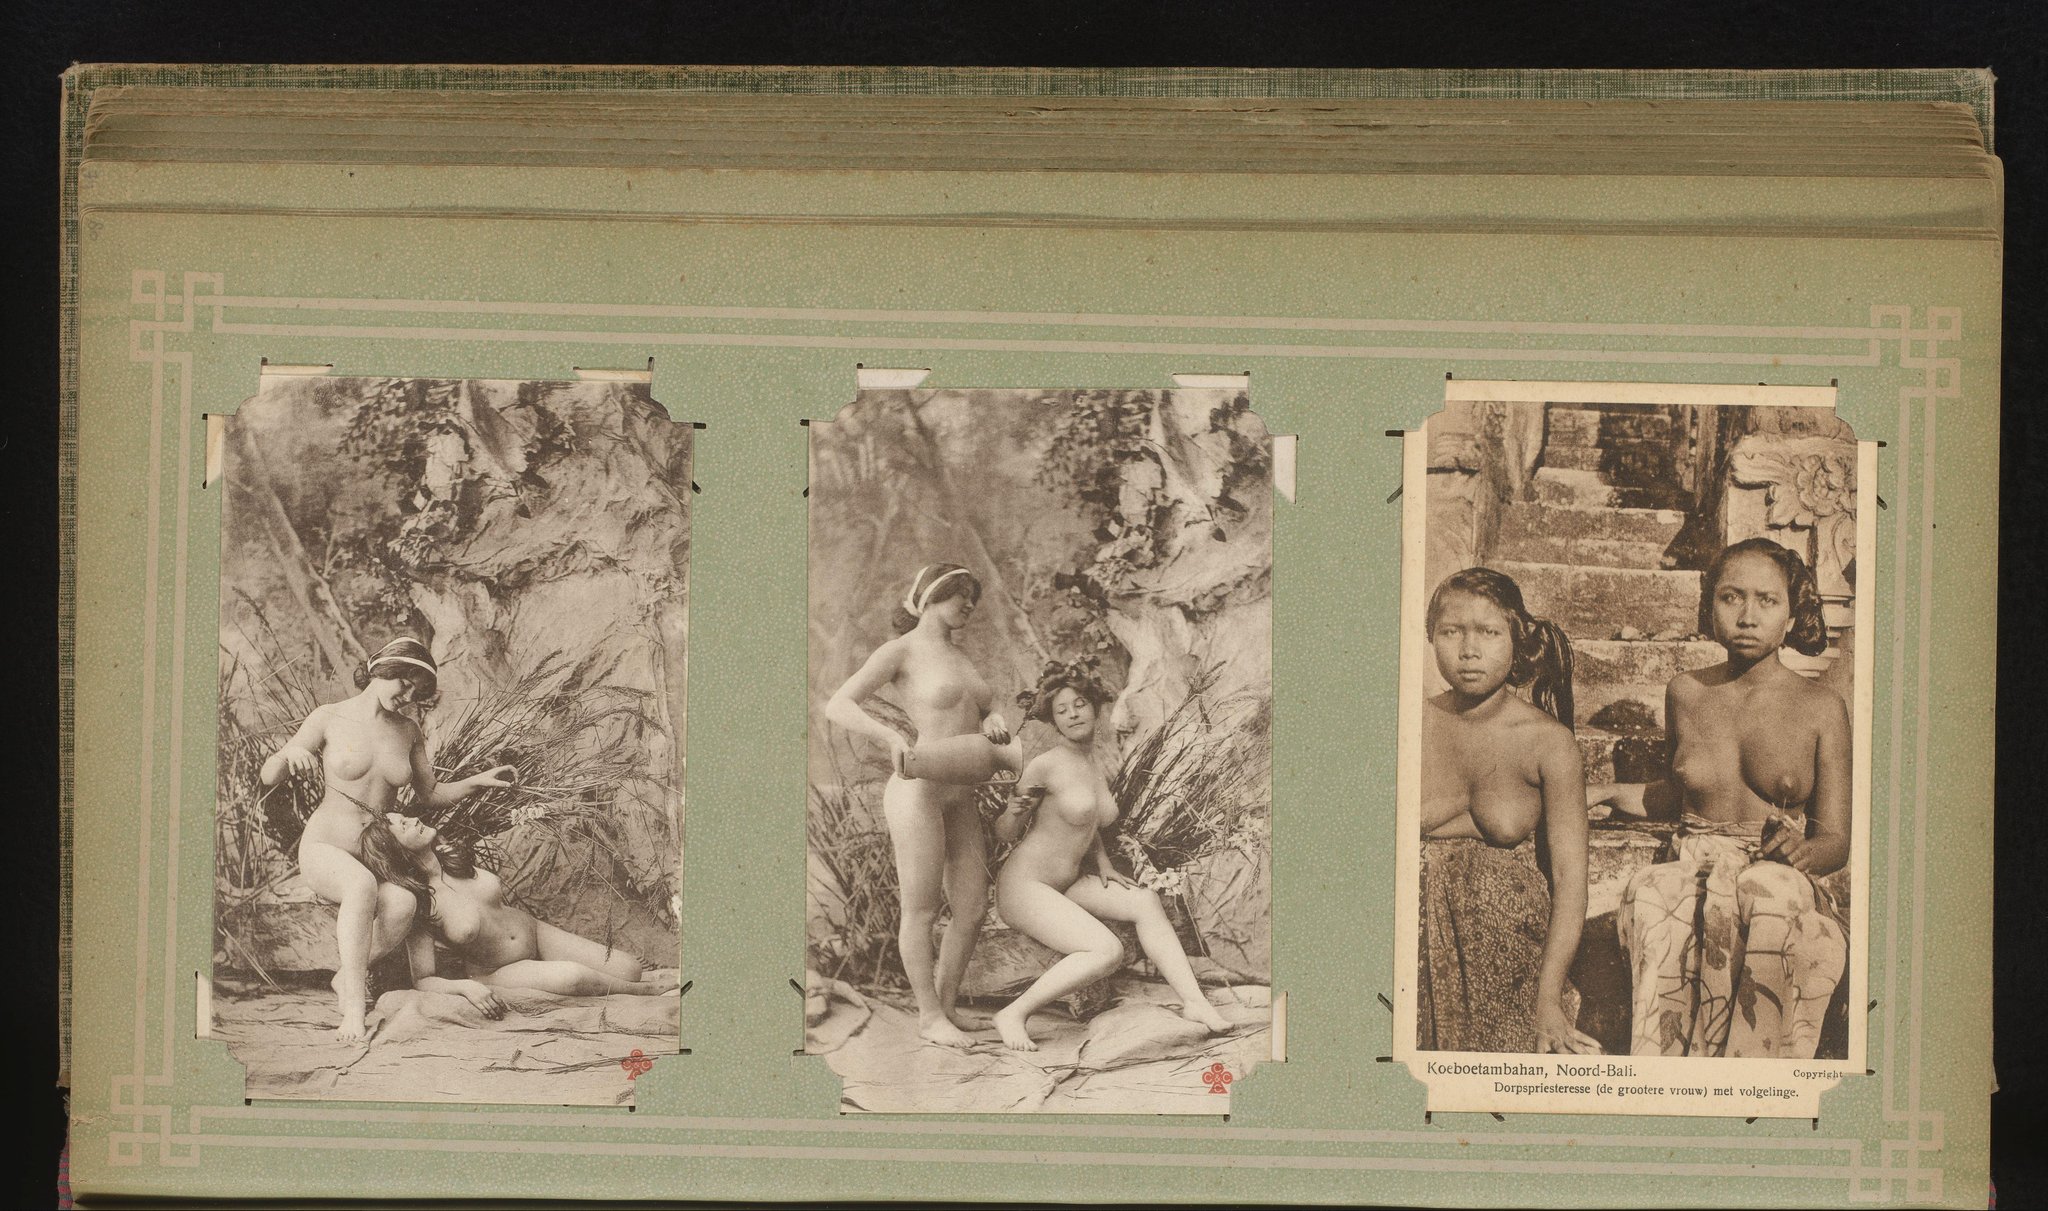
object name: photomechanical print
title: Drie portretten van twee naakte vrouwen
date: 1900-1930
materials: cardboard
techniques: photograph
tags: historical persons - bb - woman, woman (showing herself) undressed, quasi-nude, adult woman (+ two persons)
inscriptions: monogram: ‘C / C & C/ C’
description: Deze prenten maken deel uit van een album.